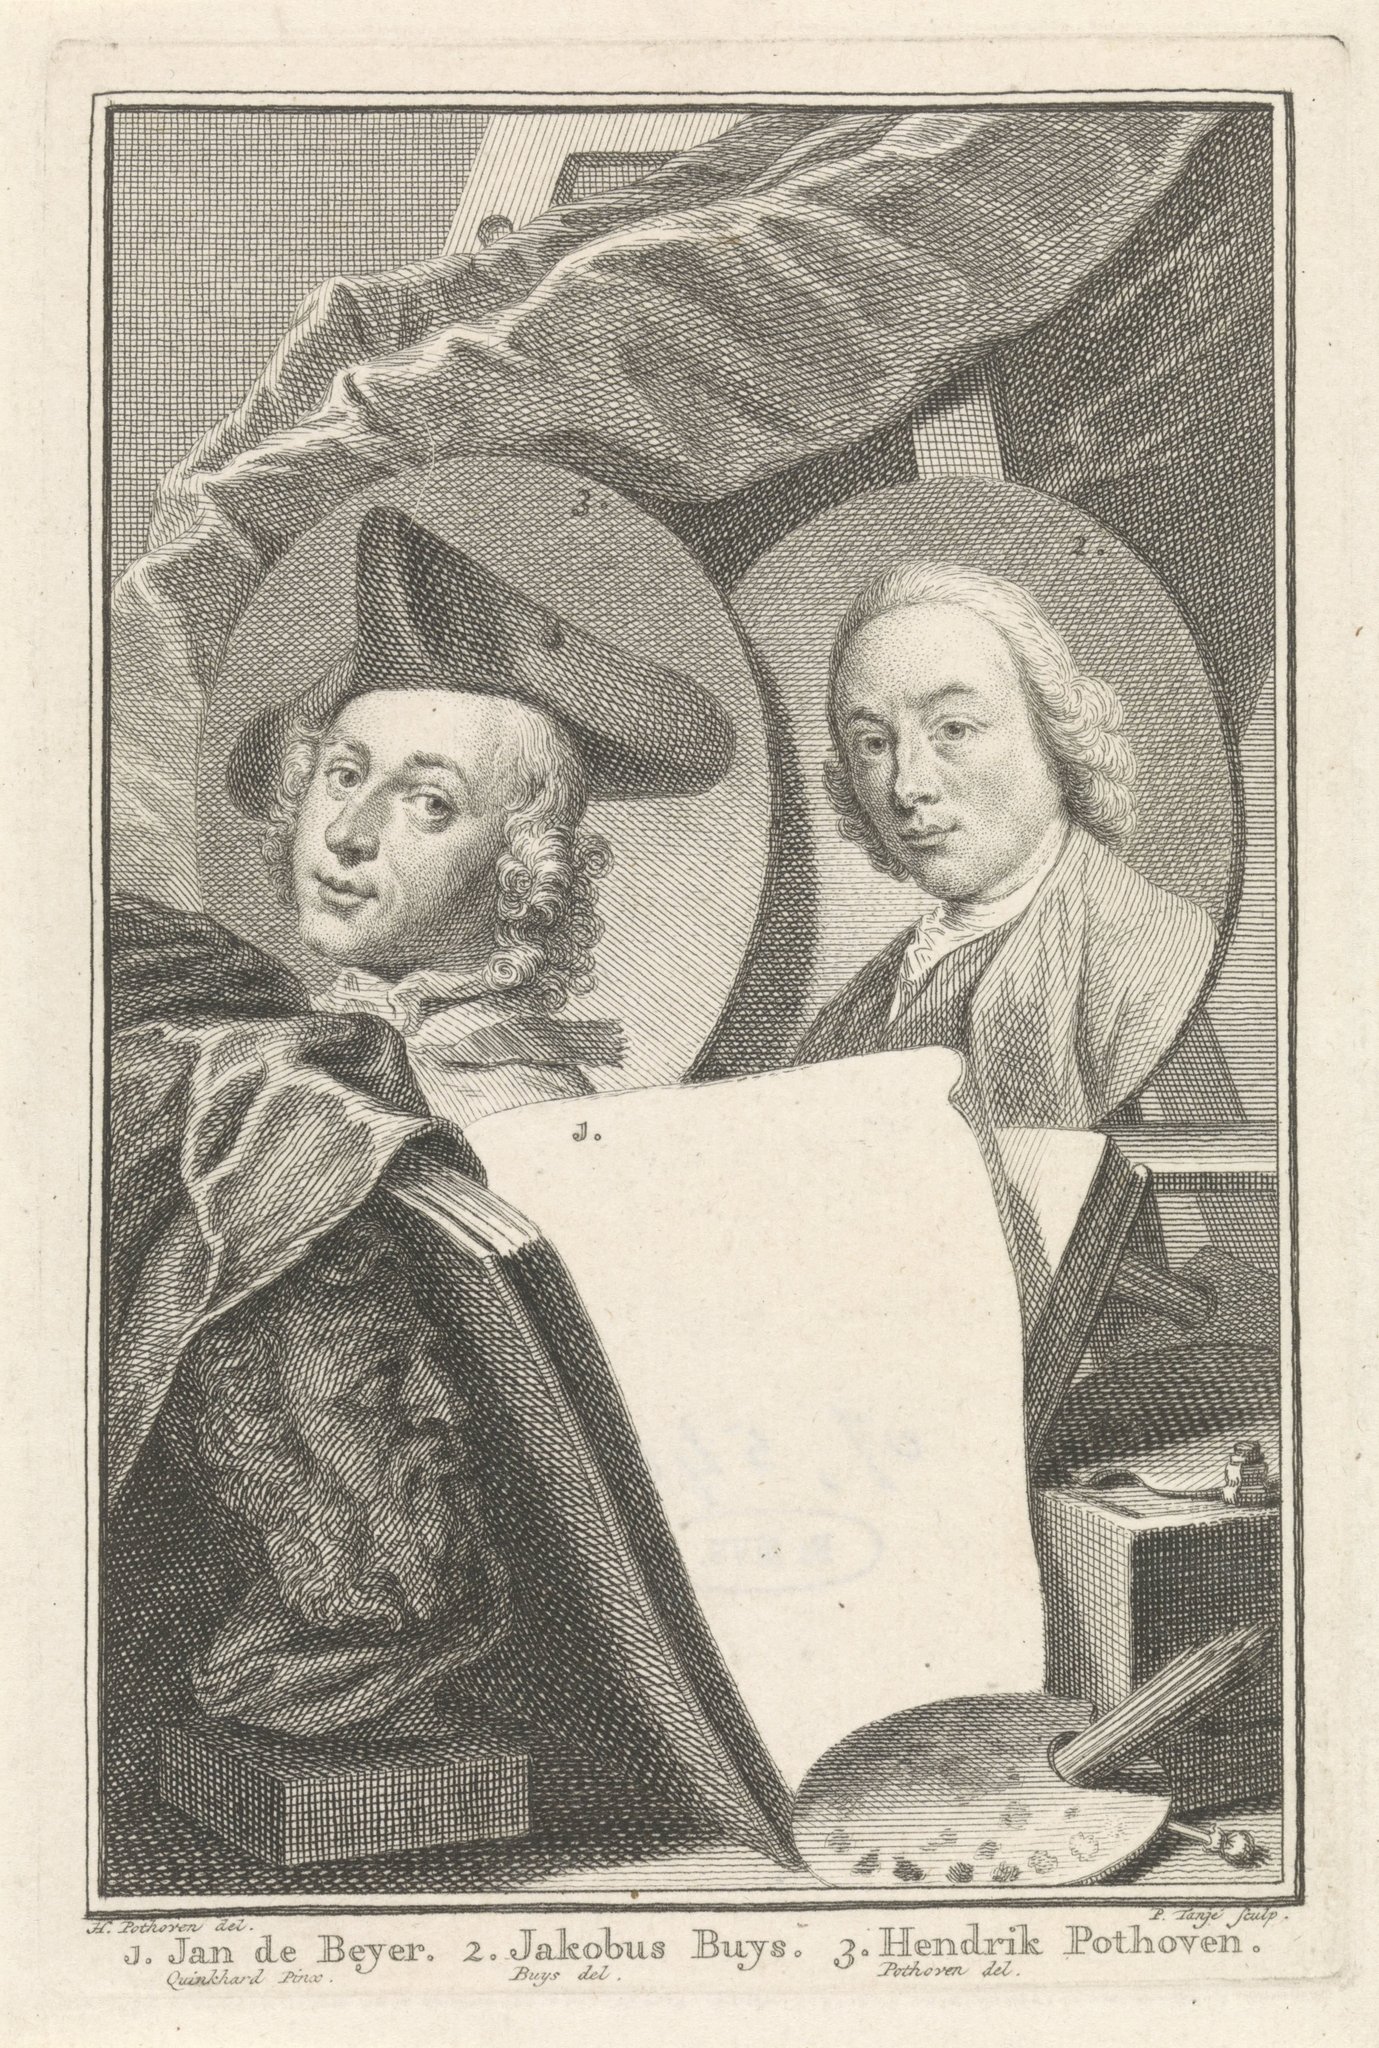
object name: print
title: Portretten van Jacobus Buys en Hendrik Pothoven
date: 1750-1751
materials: paper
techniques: engraving, etching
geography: amsterdam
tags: the hague, painter, print maker, draughtsman, hendrik pothoven, jacobus buys, tools, implements of painter, portrait, self-portrait of artist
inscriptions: collector's mark: Lugt 2228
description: Latere staat van deze prent gebruikt in: Gool, Johan van. De nieuwe schouburg der Nederlantsche kunstschilders en schilderessen. Den Haag 1751, dl. 2.